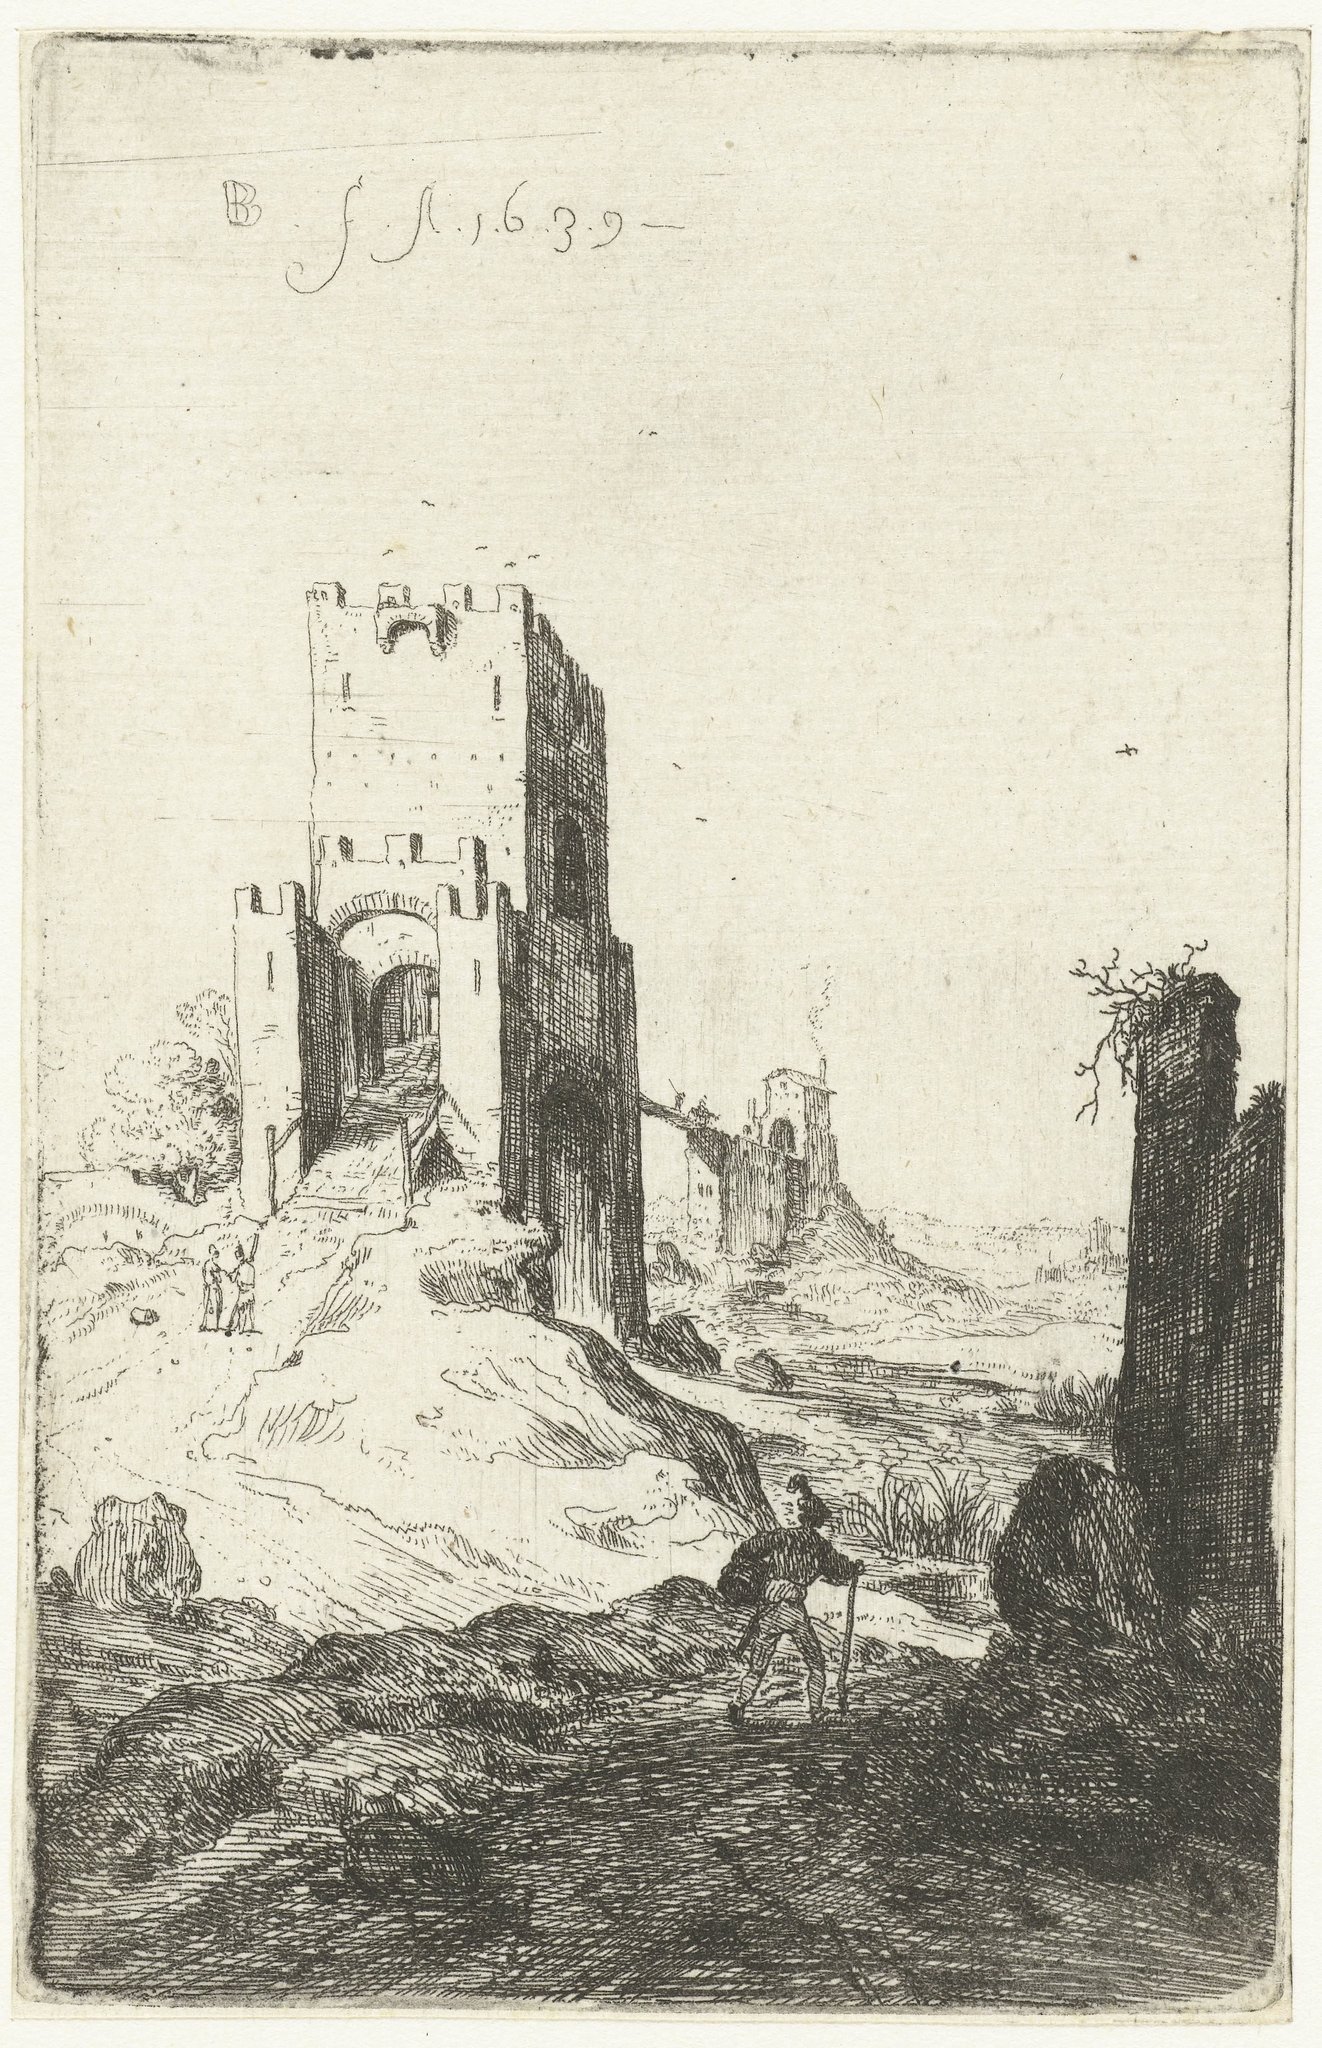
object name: print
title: Ponte Mammolo te Rome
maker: bartholomeus breenbergh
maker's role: draughtsman, print maker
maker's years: 1599-1657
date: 1639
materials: paper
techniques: etching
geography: netherlands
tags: landscape with bridge, viaduct or aqueduct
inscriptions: collector's mark: Lugt 240